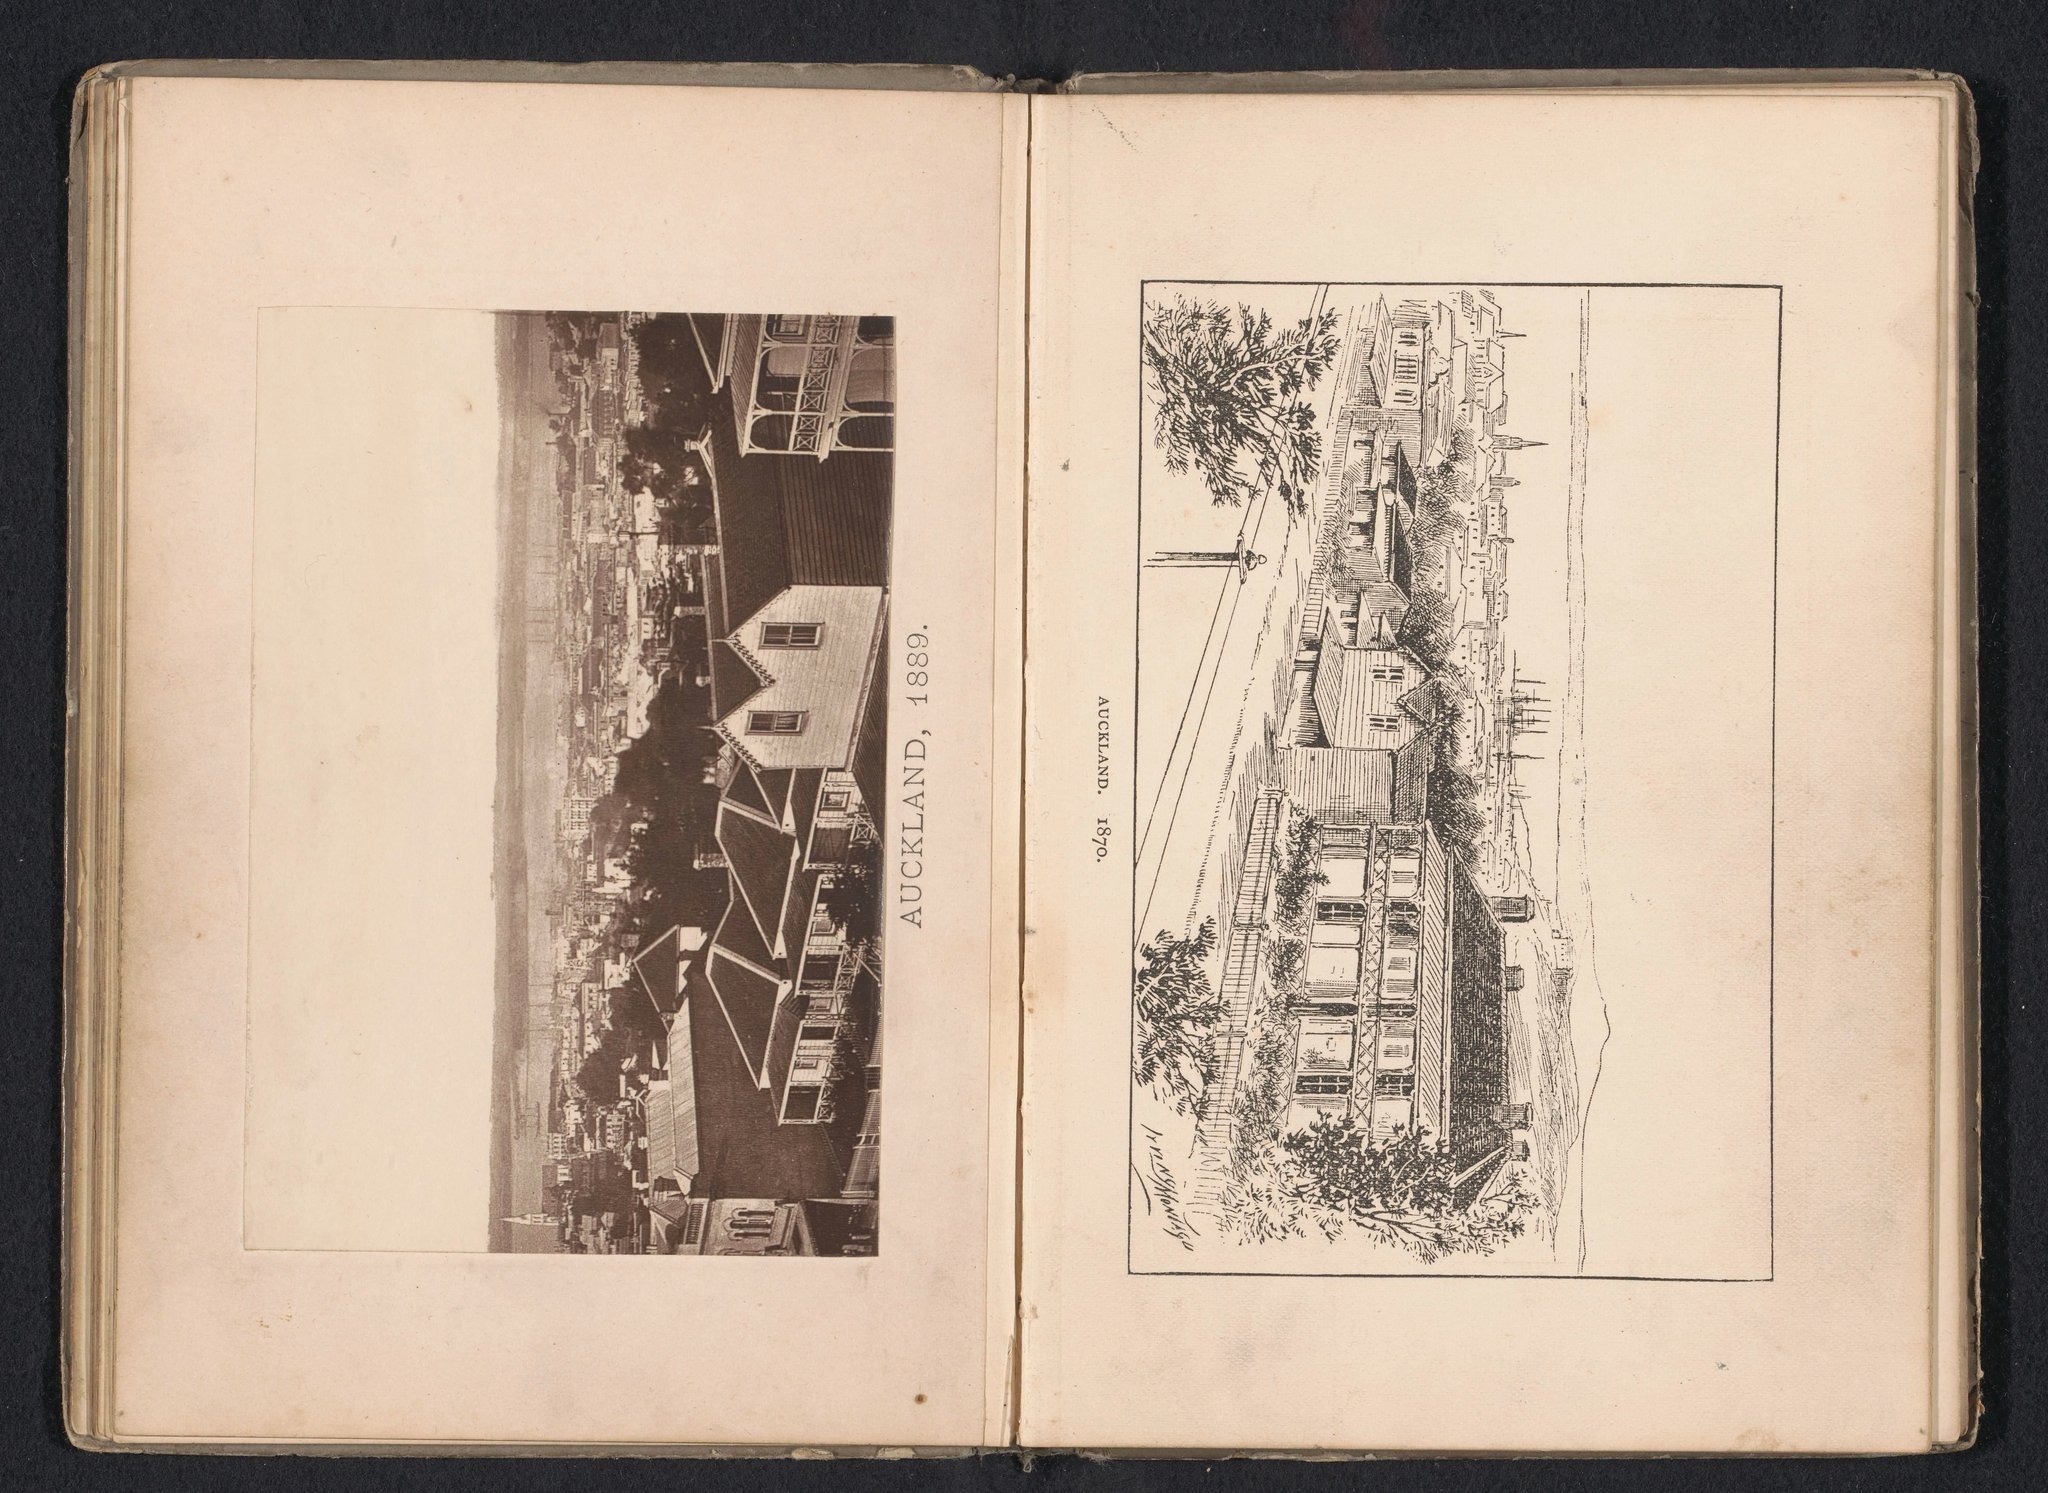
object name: photomechanical print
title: Fotoreproductie van een gezicht op Auckland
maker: Anonymous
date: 1889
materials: paper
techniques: woodburytype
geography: auckland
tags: prospect of city, town panorama, silhouette of city